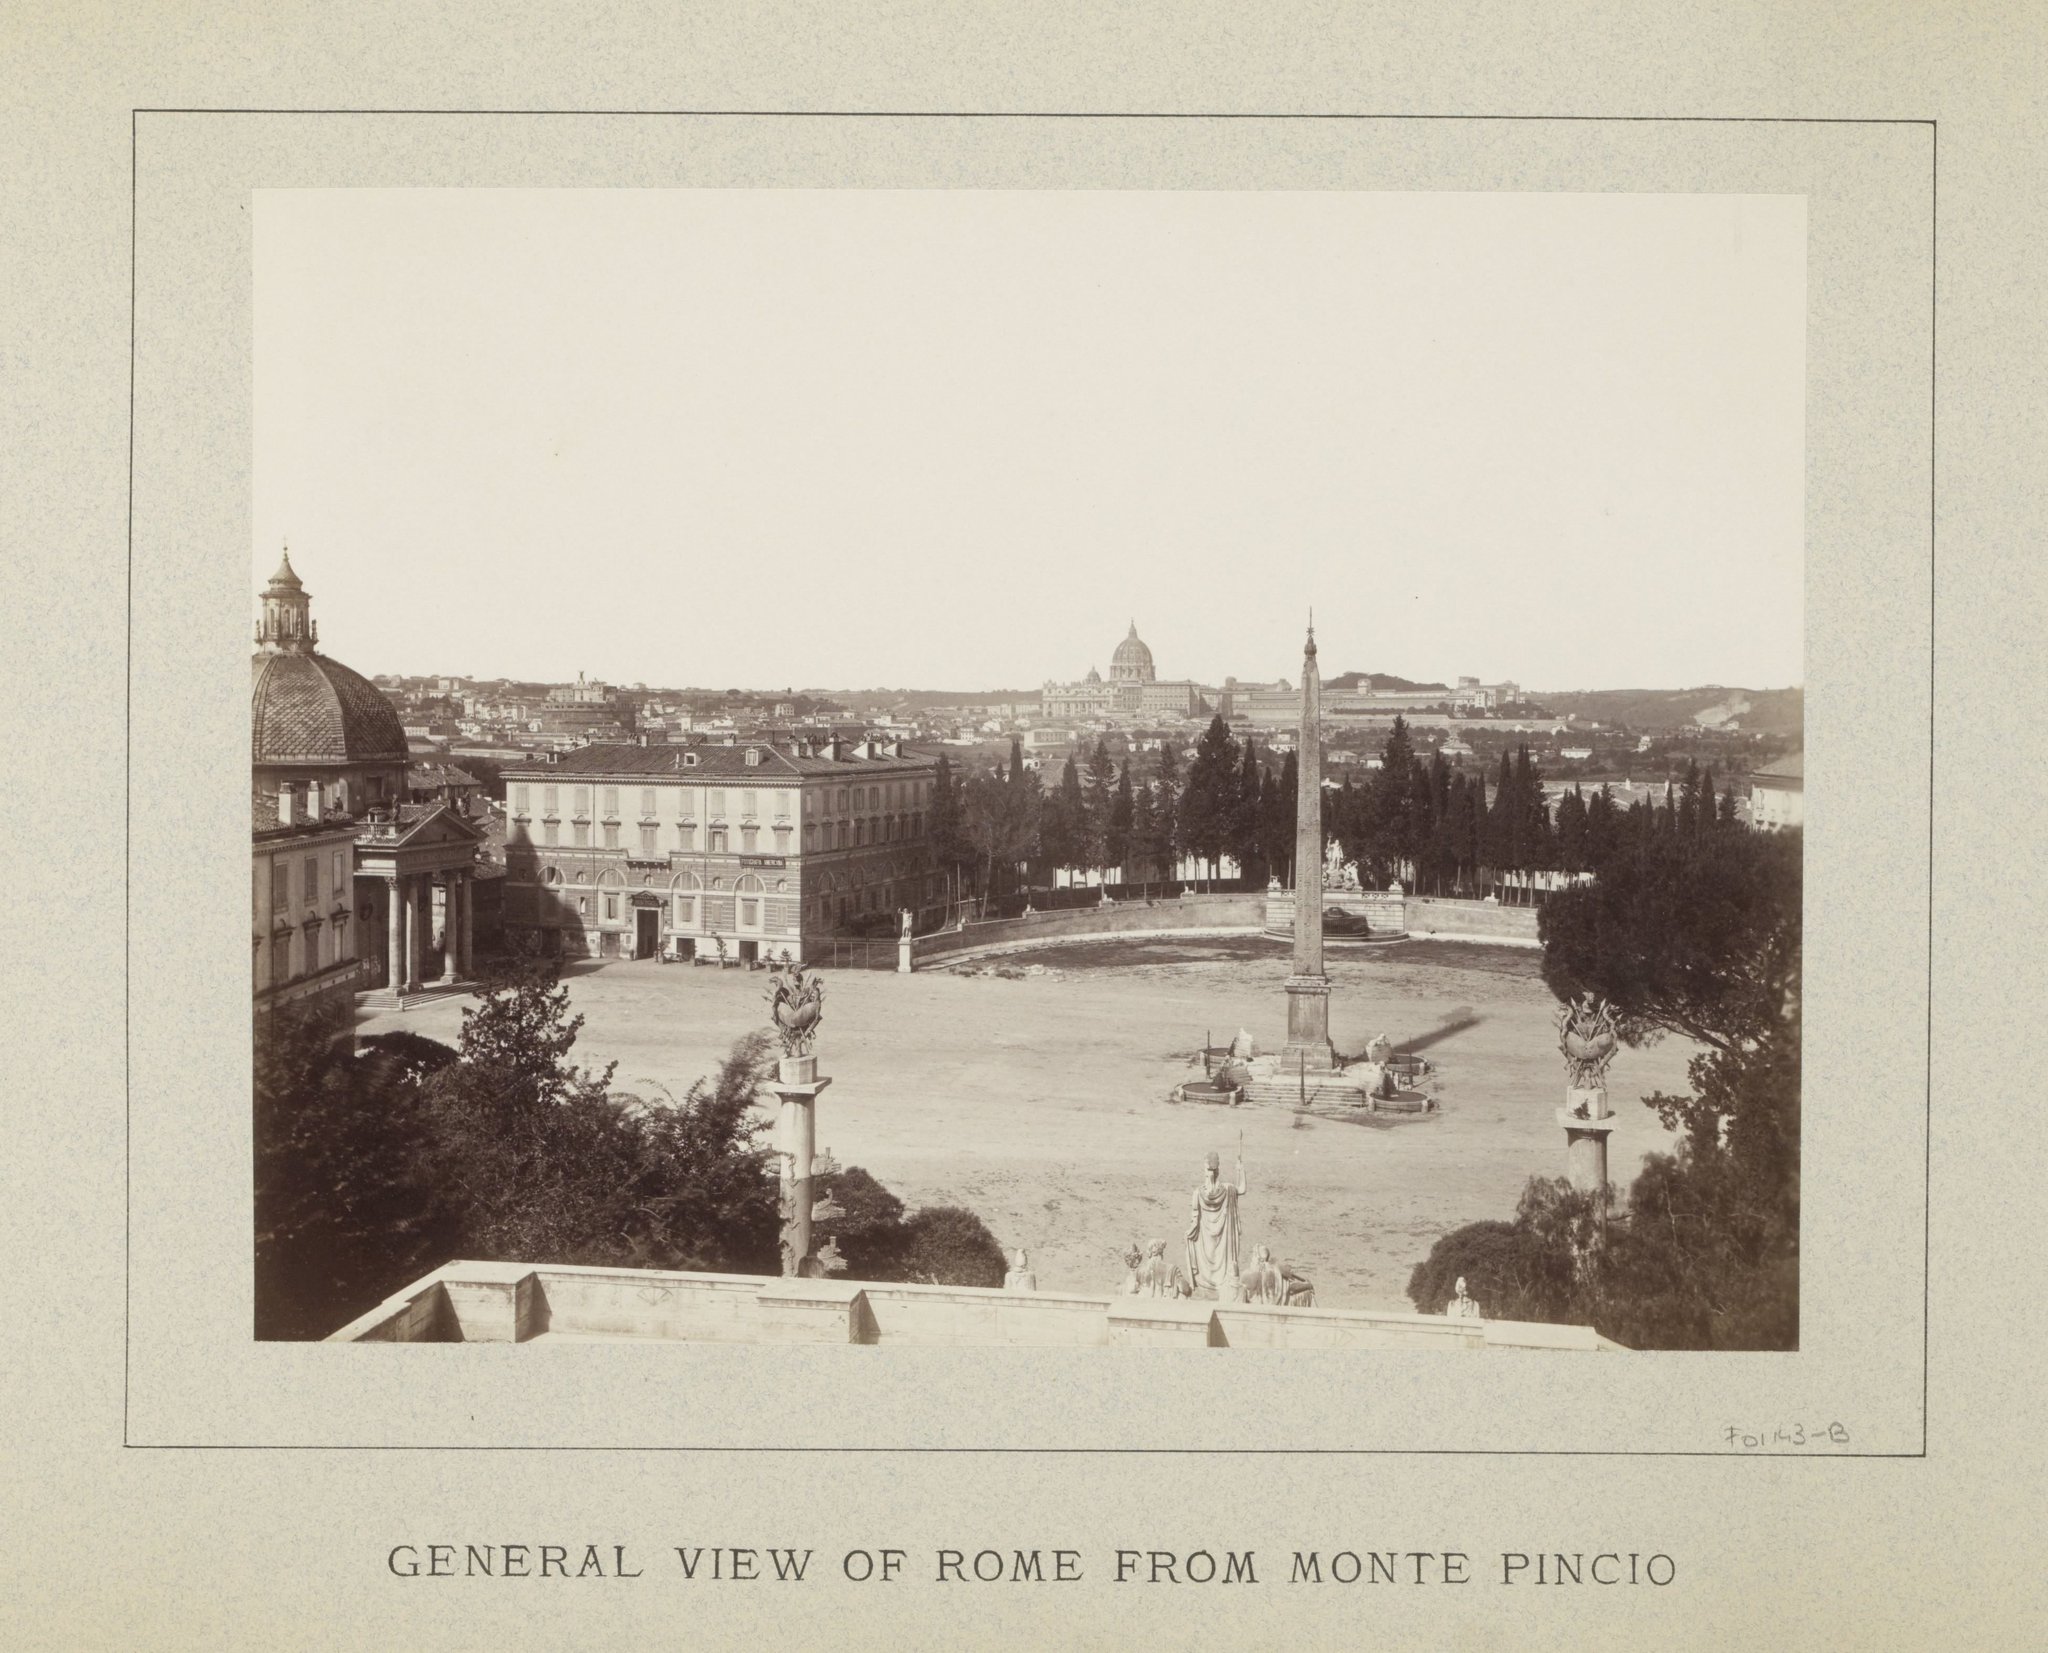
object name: photograph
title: General view of Rome from Monte Pincio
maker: Anonymous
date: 1860-1900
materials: photographic support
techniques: albumen print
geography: rome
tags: obelisk, needle, square, place, circus, etc. (+ city(-scape) with figures, staffage), prospect of city, town panorama, silhouette of city, rome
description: Onderdeel van Fotoalbum met opnames van bezienswaardigheden en kunstwerken in Rome.